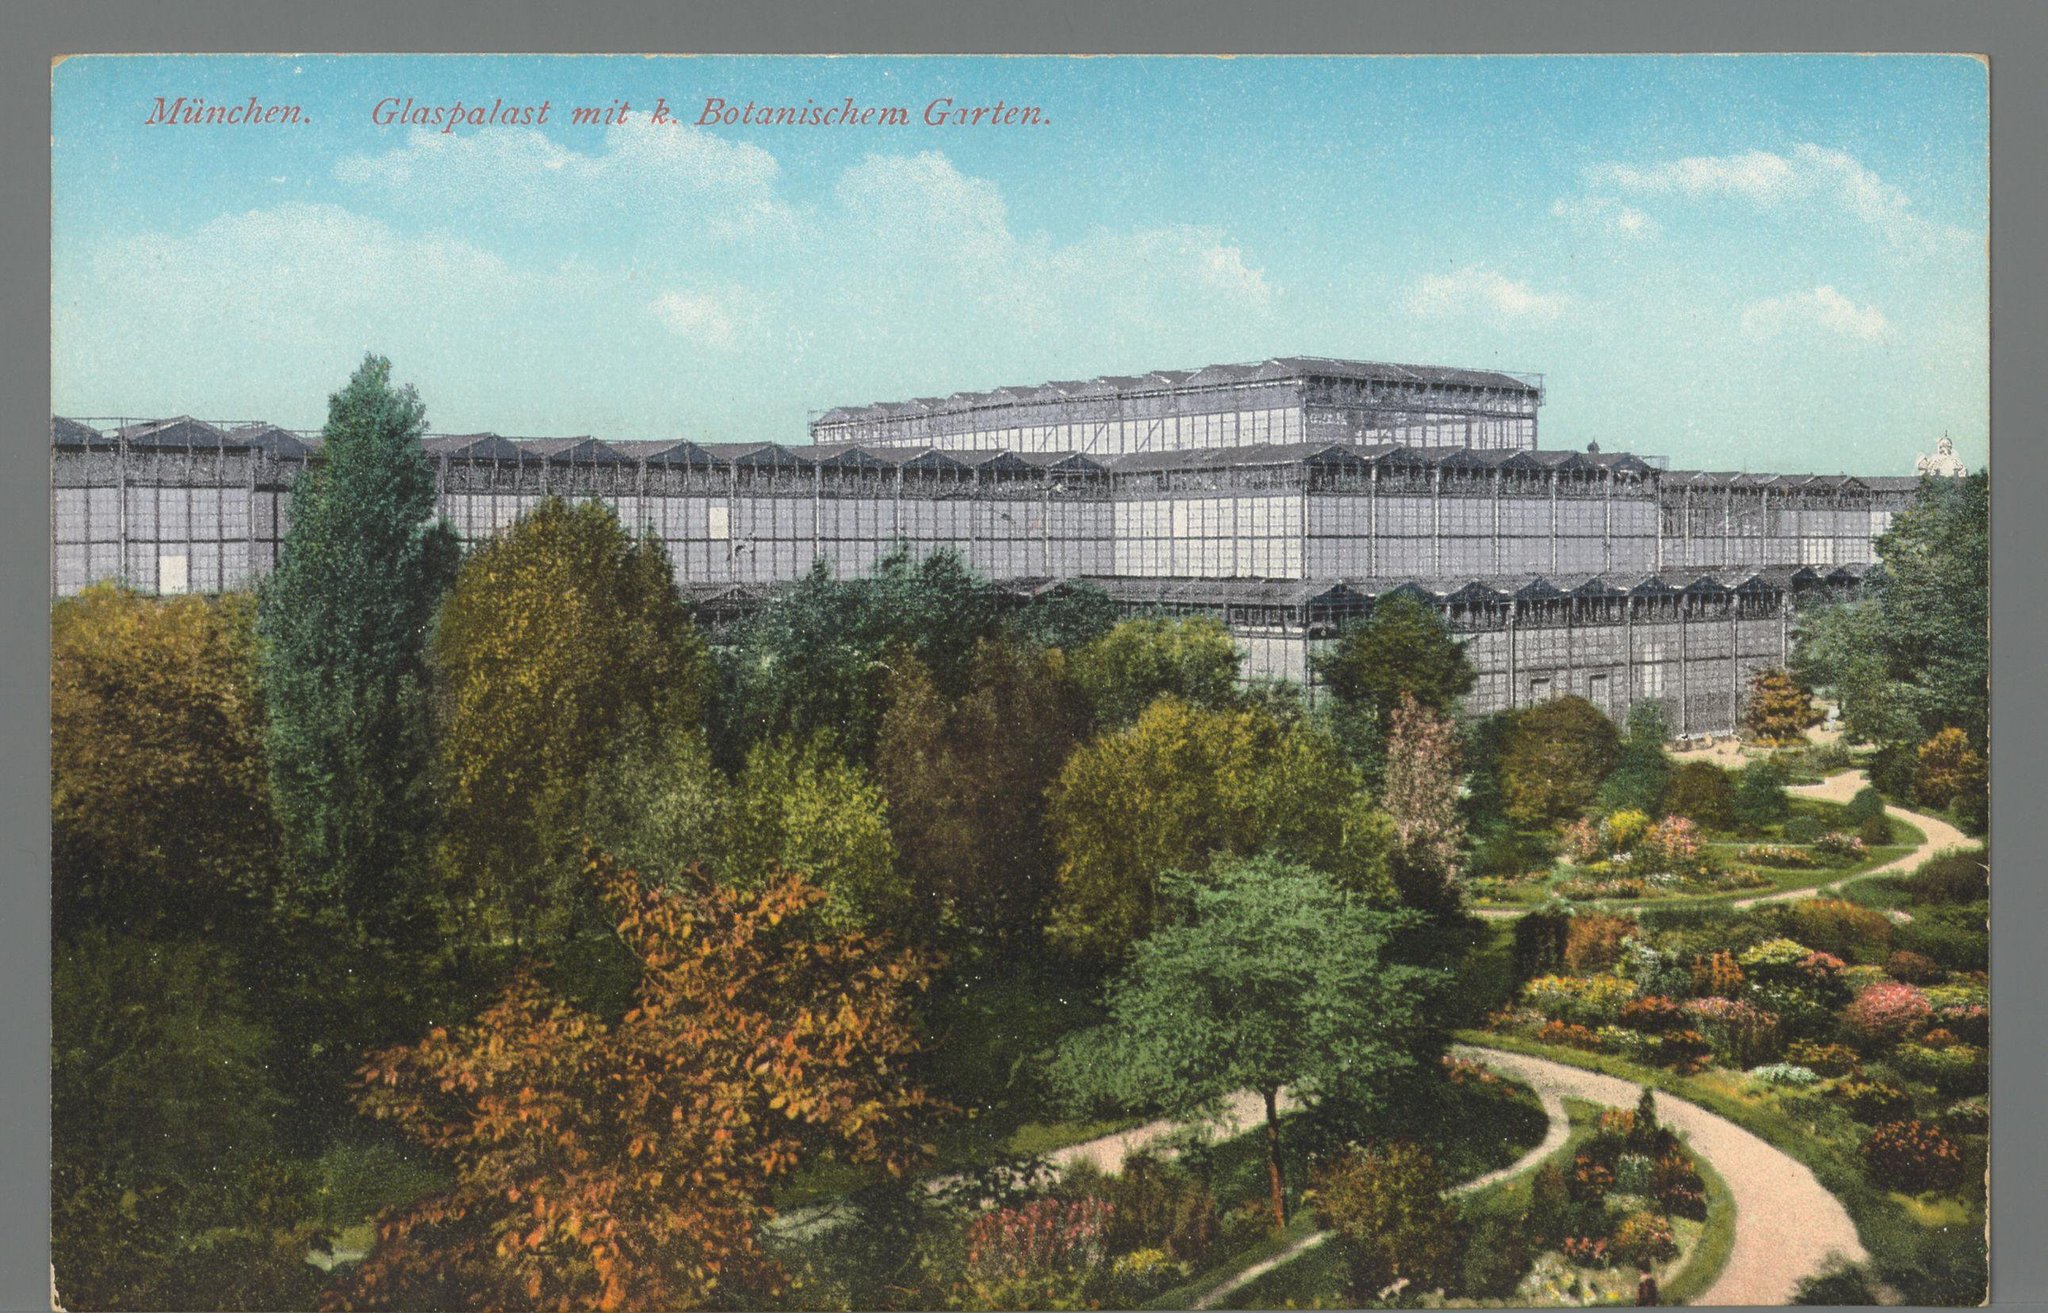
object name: print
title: München. Glaspalast mit k. Botanischem Garten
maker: Anonymous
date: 1905-1931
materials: cardboard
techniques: lithograph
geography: munich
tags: palace, botanic garden, 'hortus botanicus'